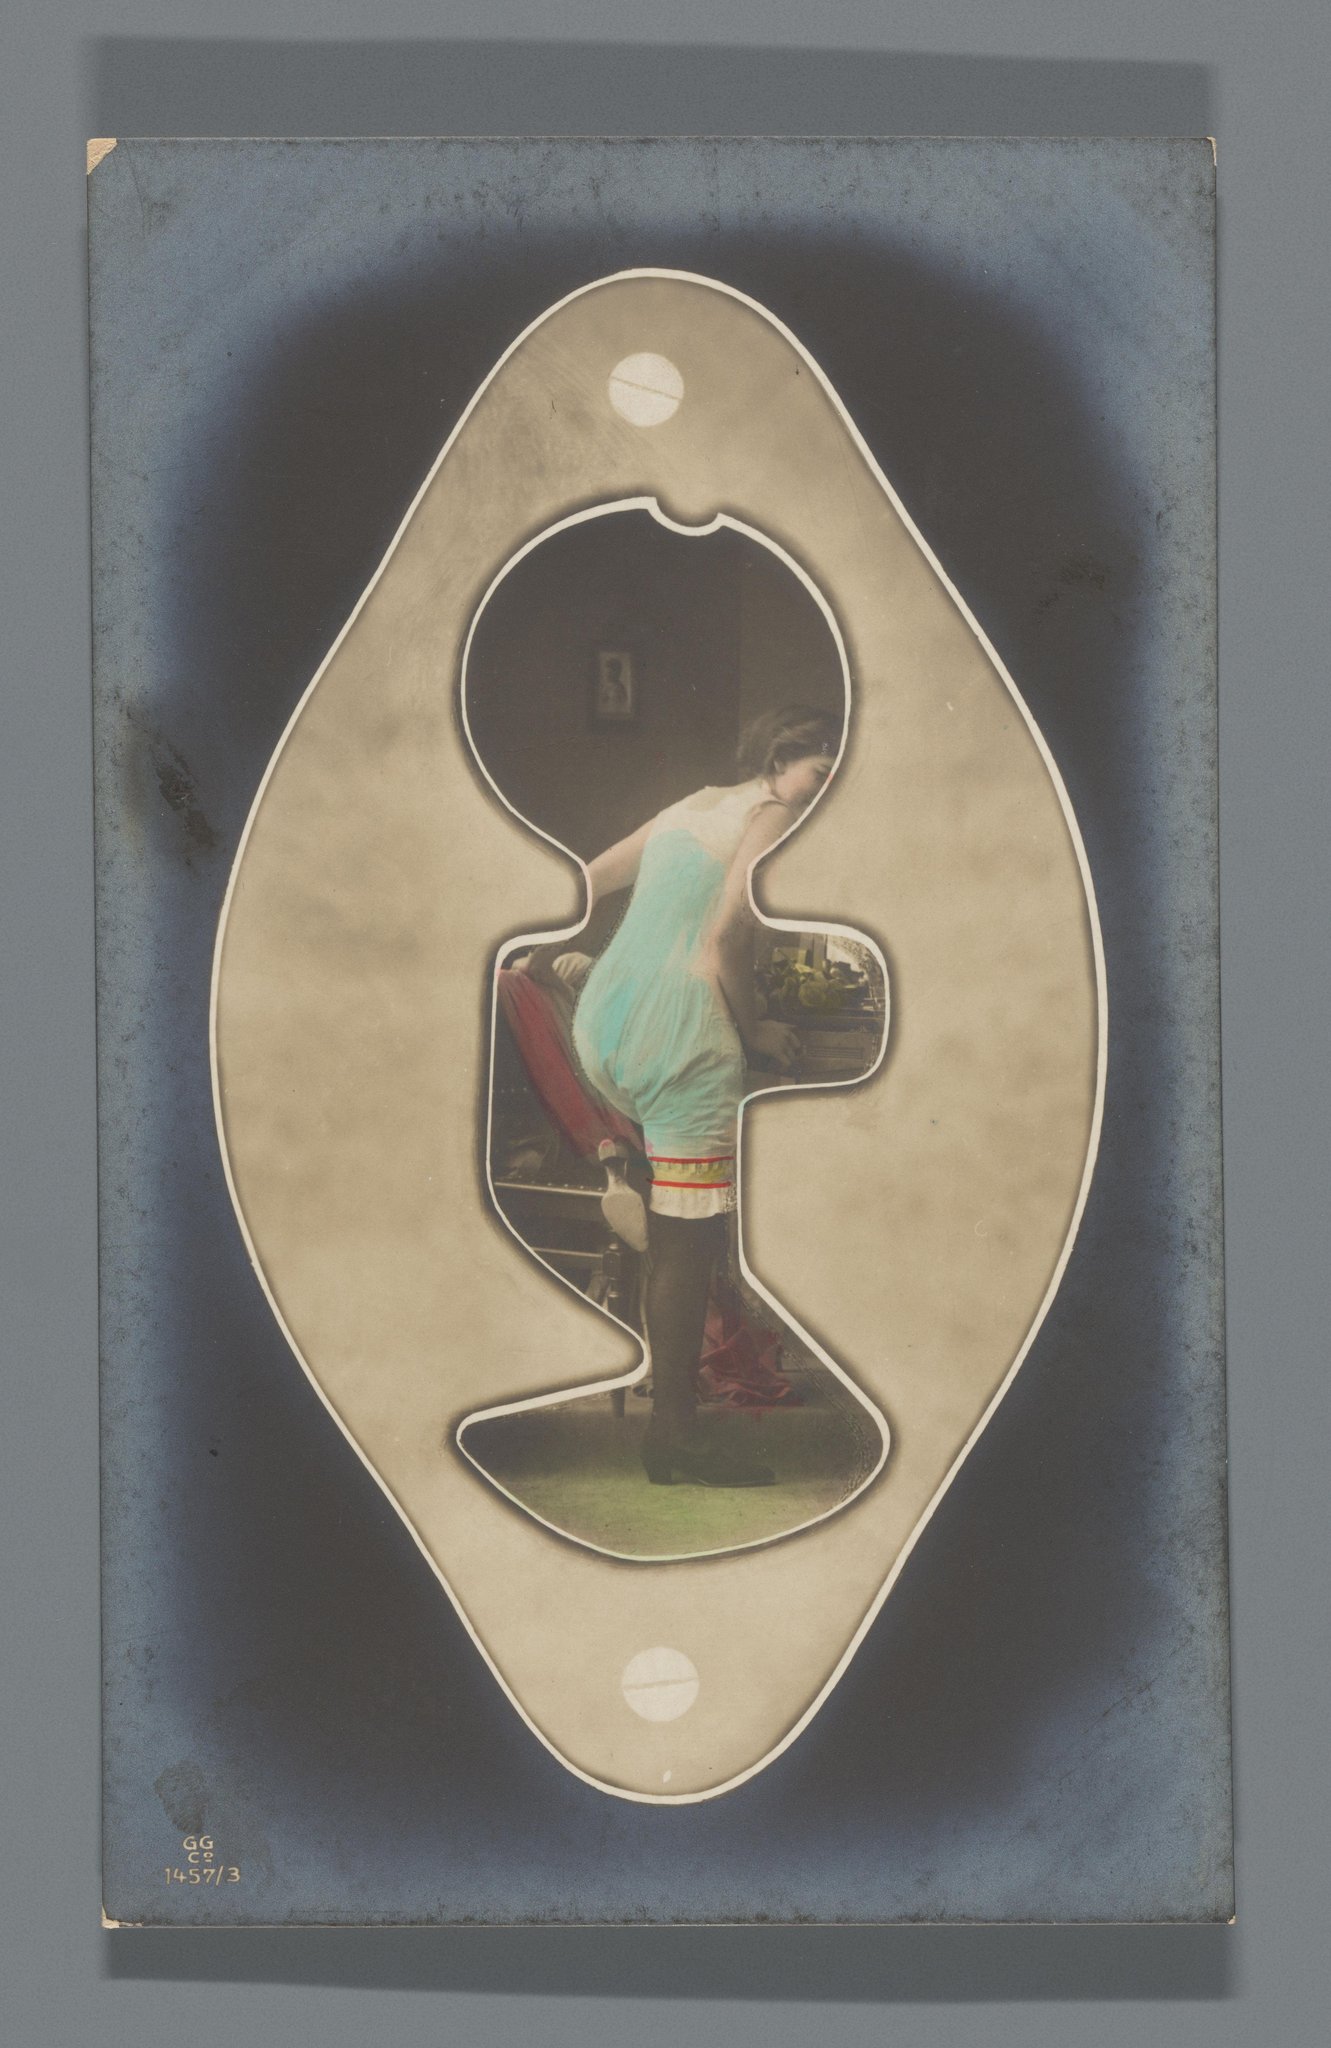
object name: ansichtkaart, prentbriefkaart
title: Vrouw die zich ontkleedt en opmaakt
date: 1920-1930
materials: paper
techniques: gelatin silver print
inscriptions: inscription: ‘GG / Co / 1457/3’, inscription: ‘P.R.A.’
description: Een van zes postkaarten/prentbriefkaarten met een voorstelling van een vrouw die zich ontkleedt en opmaakt, gezien door een sleutelgat.